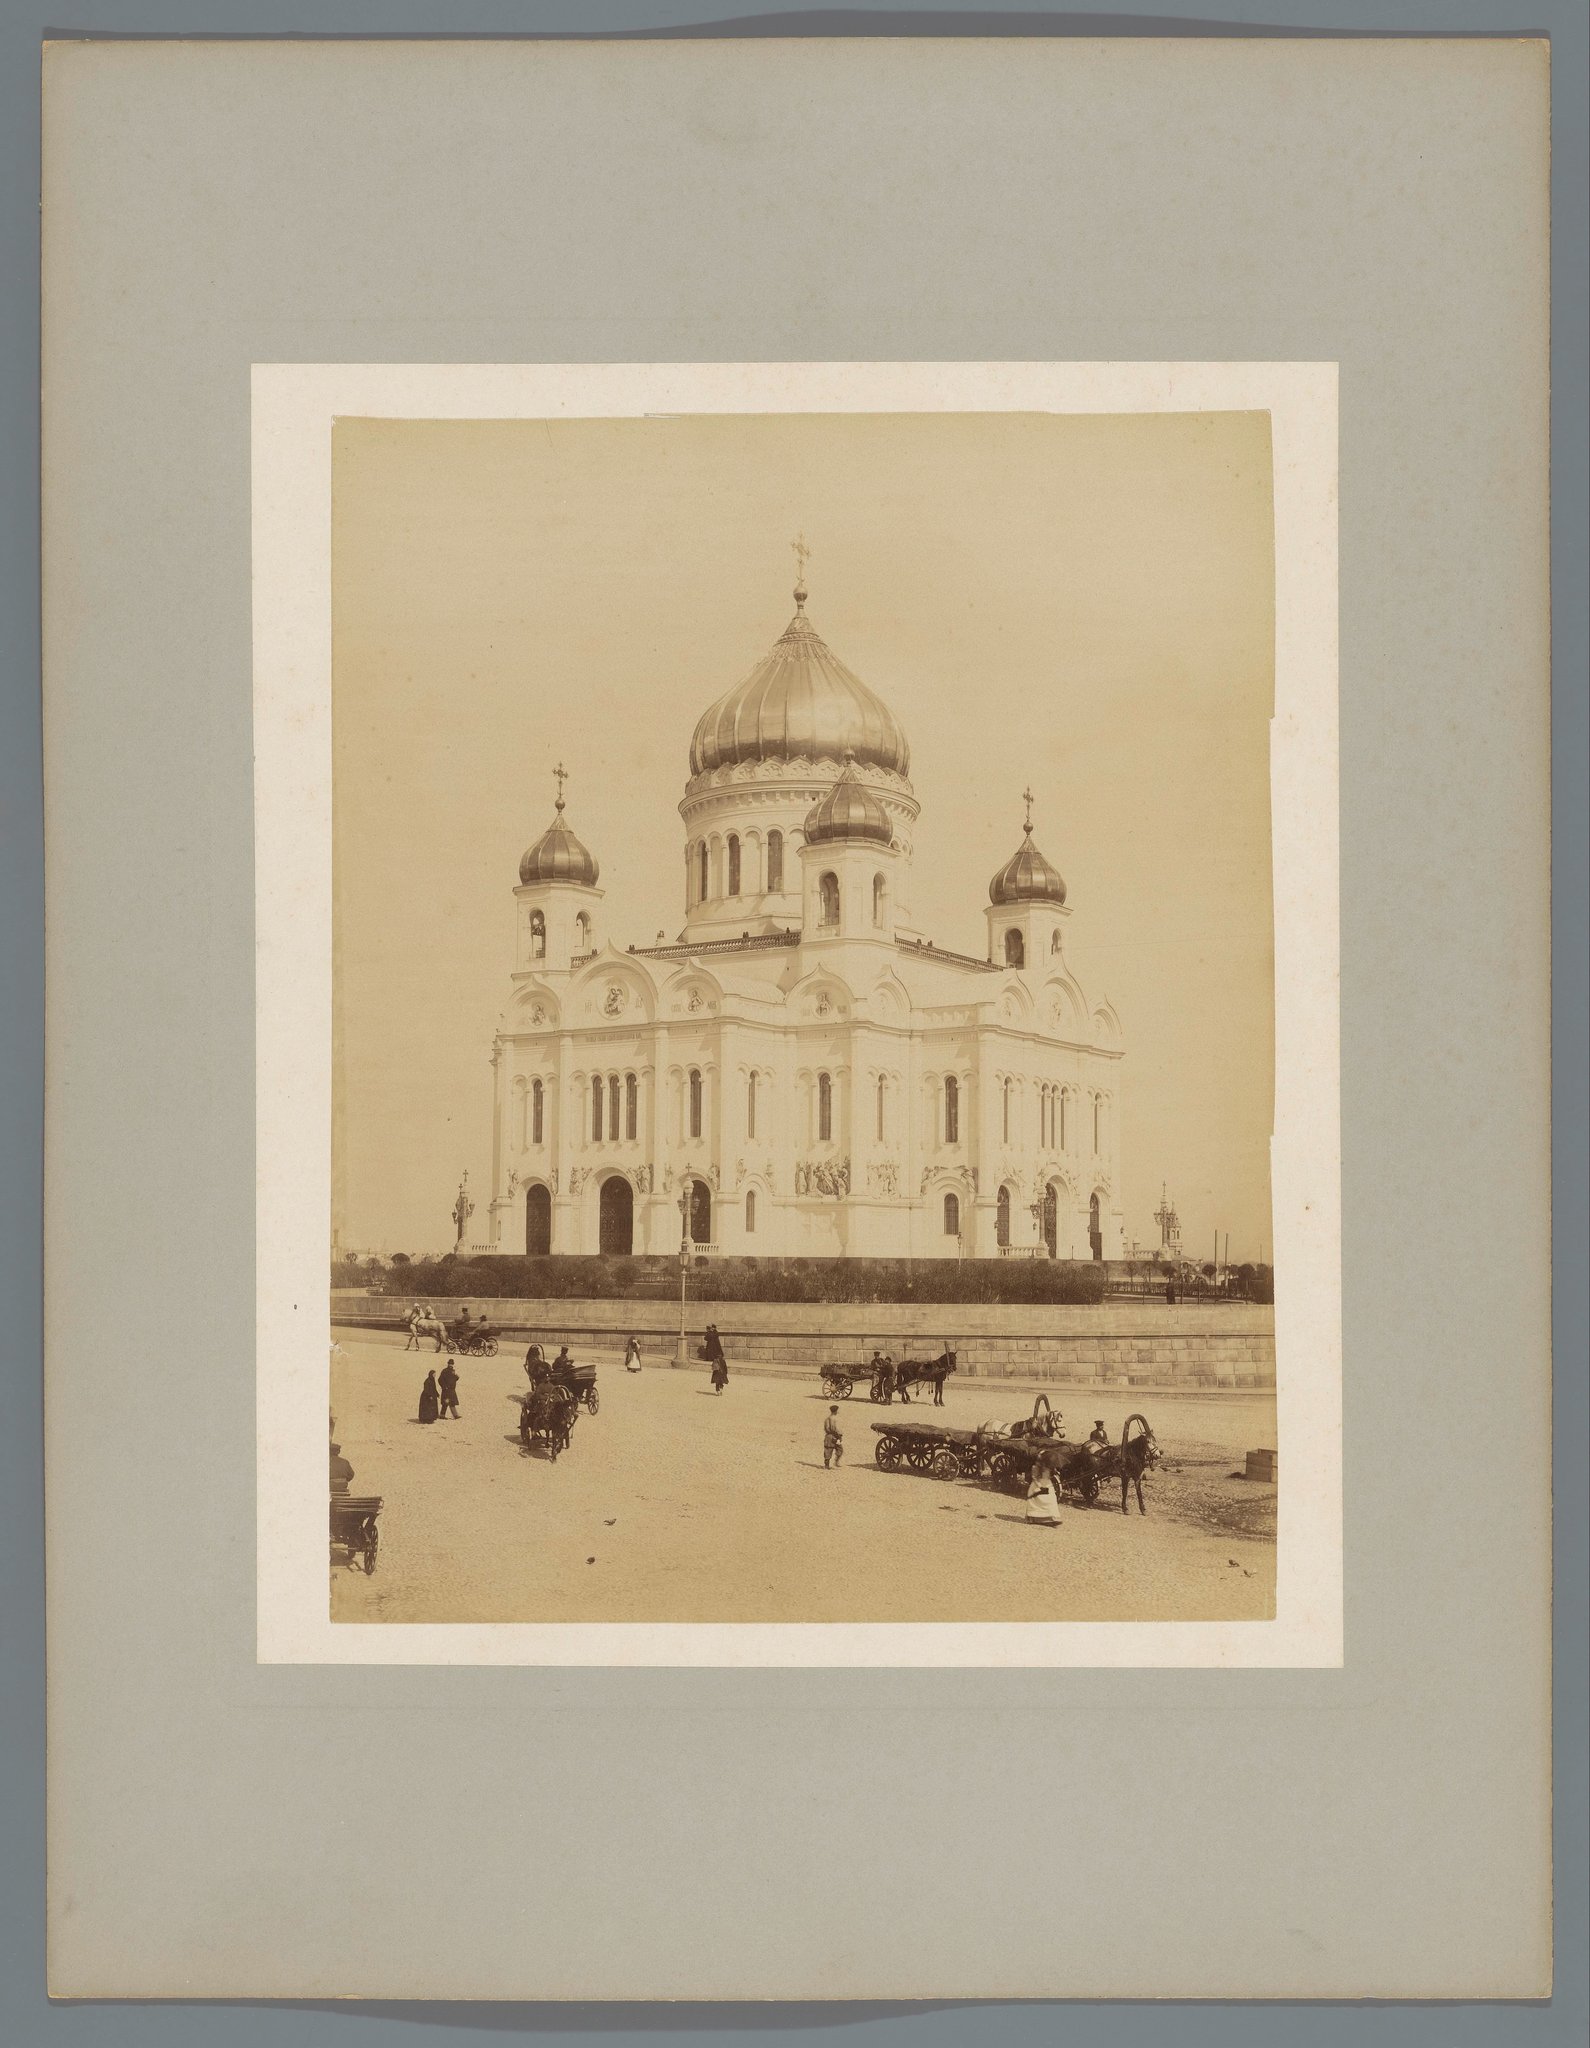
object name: photograph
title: Christus-Verlosserkathedraal in Moskou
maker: Anonymous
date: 1860-1890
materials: cardboard, paper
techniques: albumen print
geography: moscow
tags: russian orthodox church